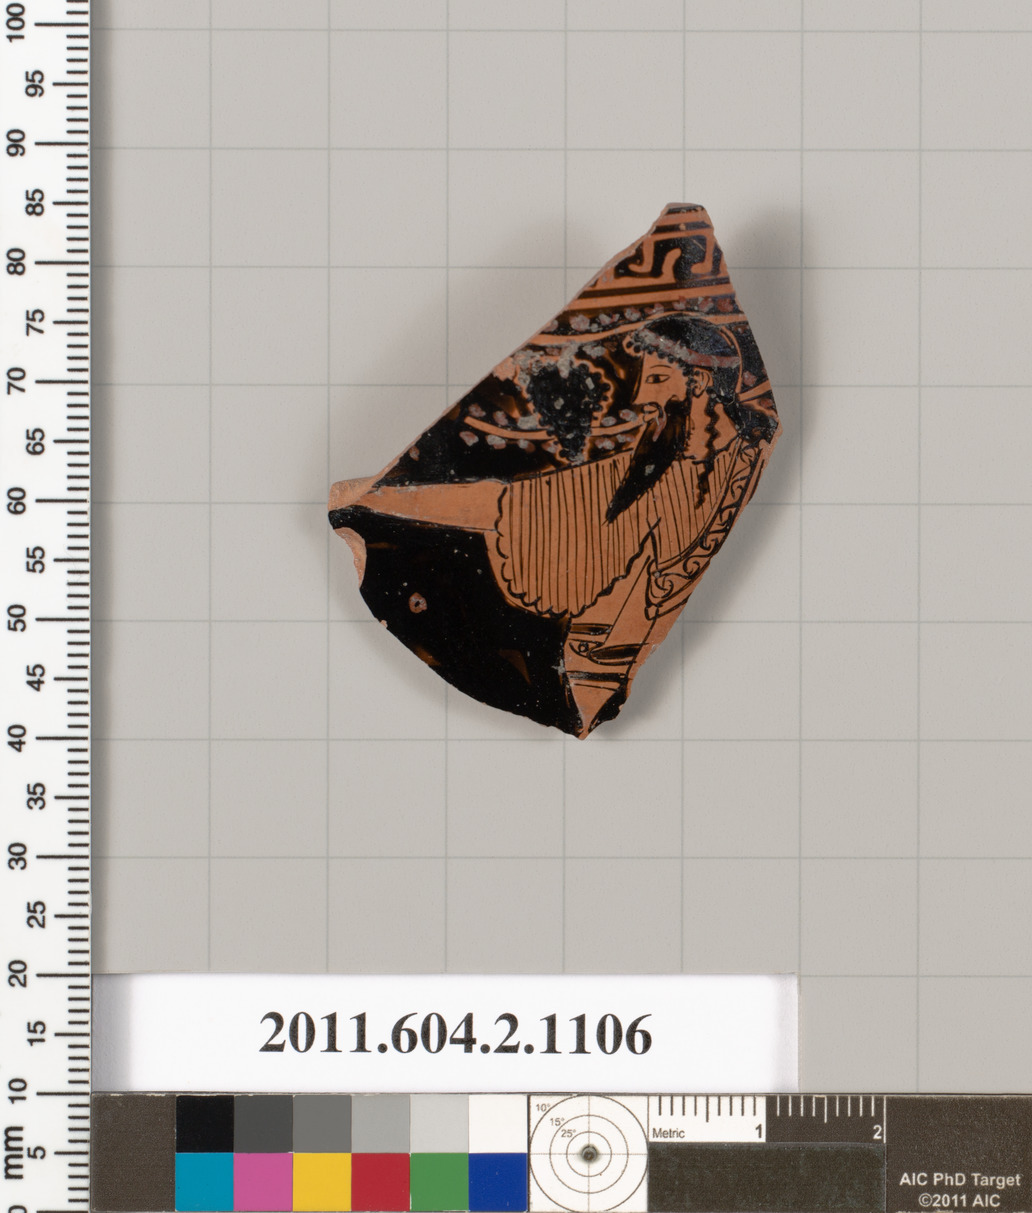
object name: lekythos fragment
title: Terracotta fragment of a lekythos (oil flask)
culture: greek, attic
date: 500-480 BCE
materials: terracotta